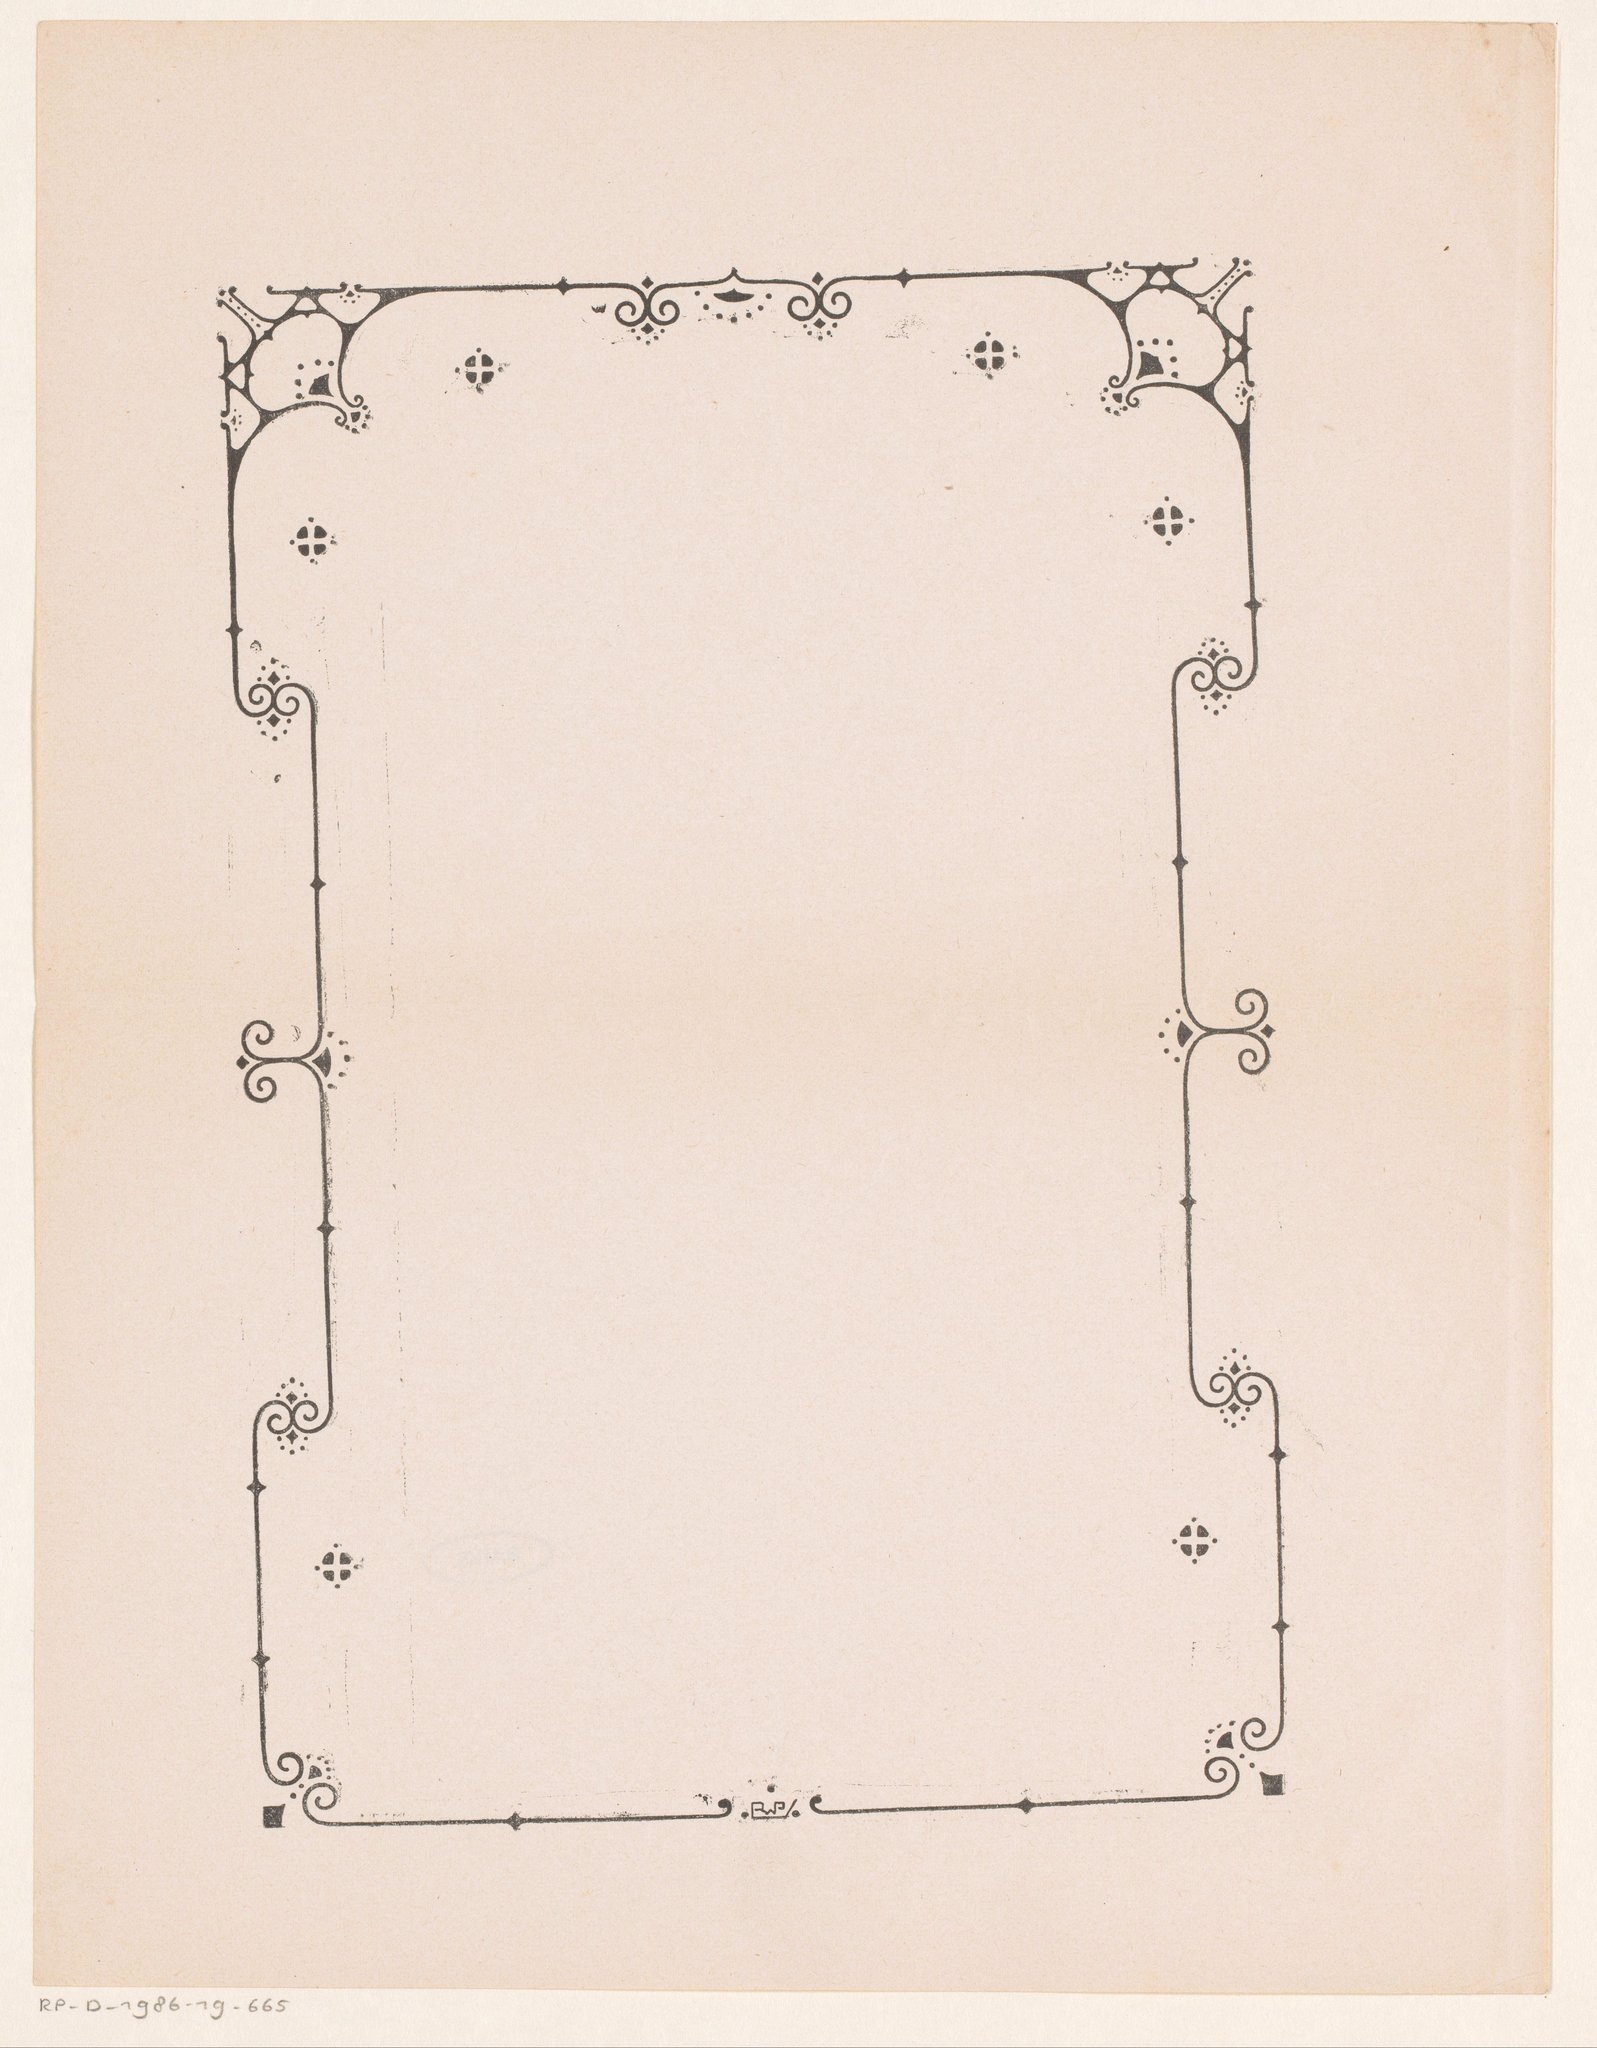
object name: photomechanical print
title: Kader voor Elsevier's Geïllustreerd Maandschrift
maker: reinier willem petrus de vries (1874-1953)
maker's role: draughtsman, print maker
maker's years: 1874-1953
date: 1905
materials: paper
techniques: printing block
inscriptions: collector's mark: ‘R:MVS.’